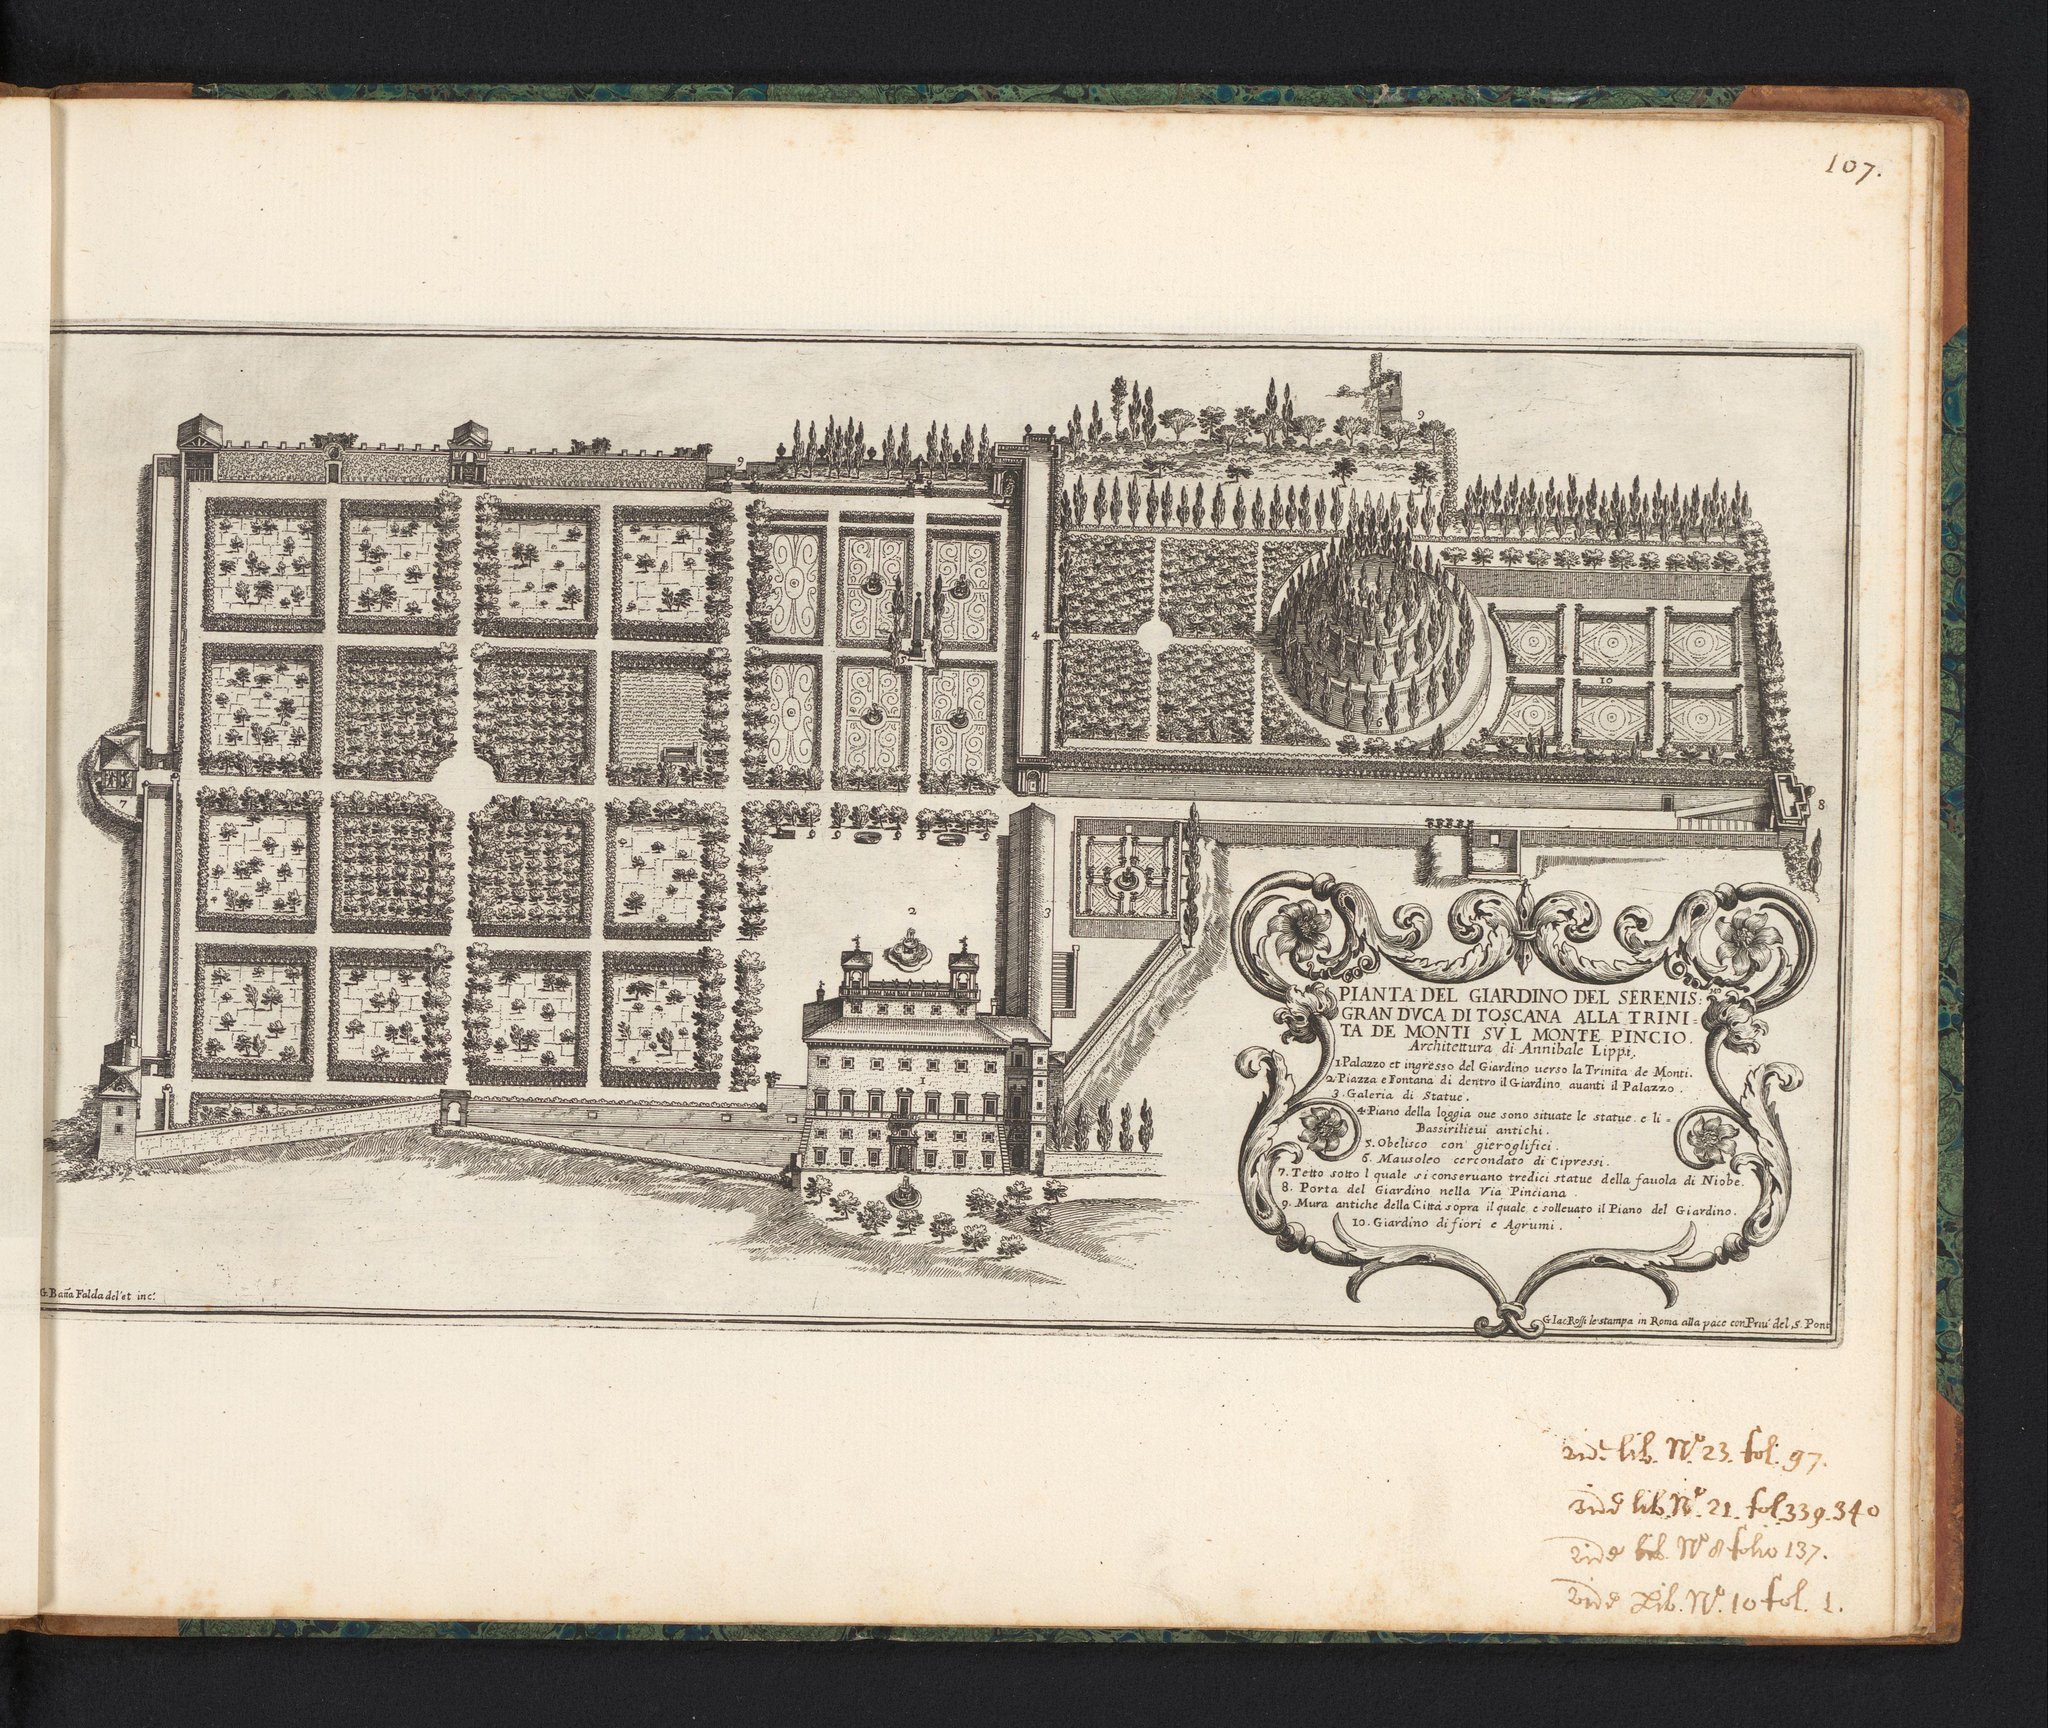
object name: album leaf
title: Plattegrond van de tuin bij de Villa Medici te Rome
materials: paper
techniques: etching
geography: vatican city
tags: plan, map of garden, garden, hôtel, i.e. small palace in city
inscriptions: number: ‘107’, inscription: ‘Ende lib. No. 23. fol. 97./ Ende lib. No. 21. fol. 339. 340...’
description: Plattegrond van de tuin bij de Villa Medici te Rome. Rechtsonder een cartouche met titel en een verklarende lijst met nummers. Prent maakt deel uit van een album.